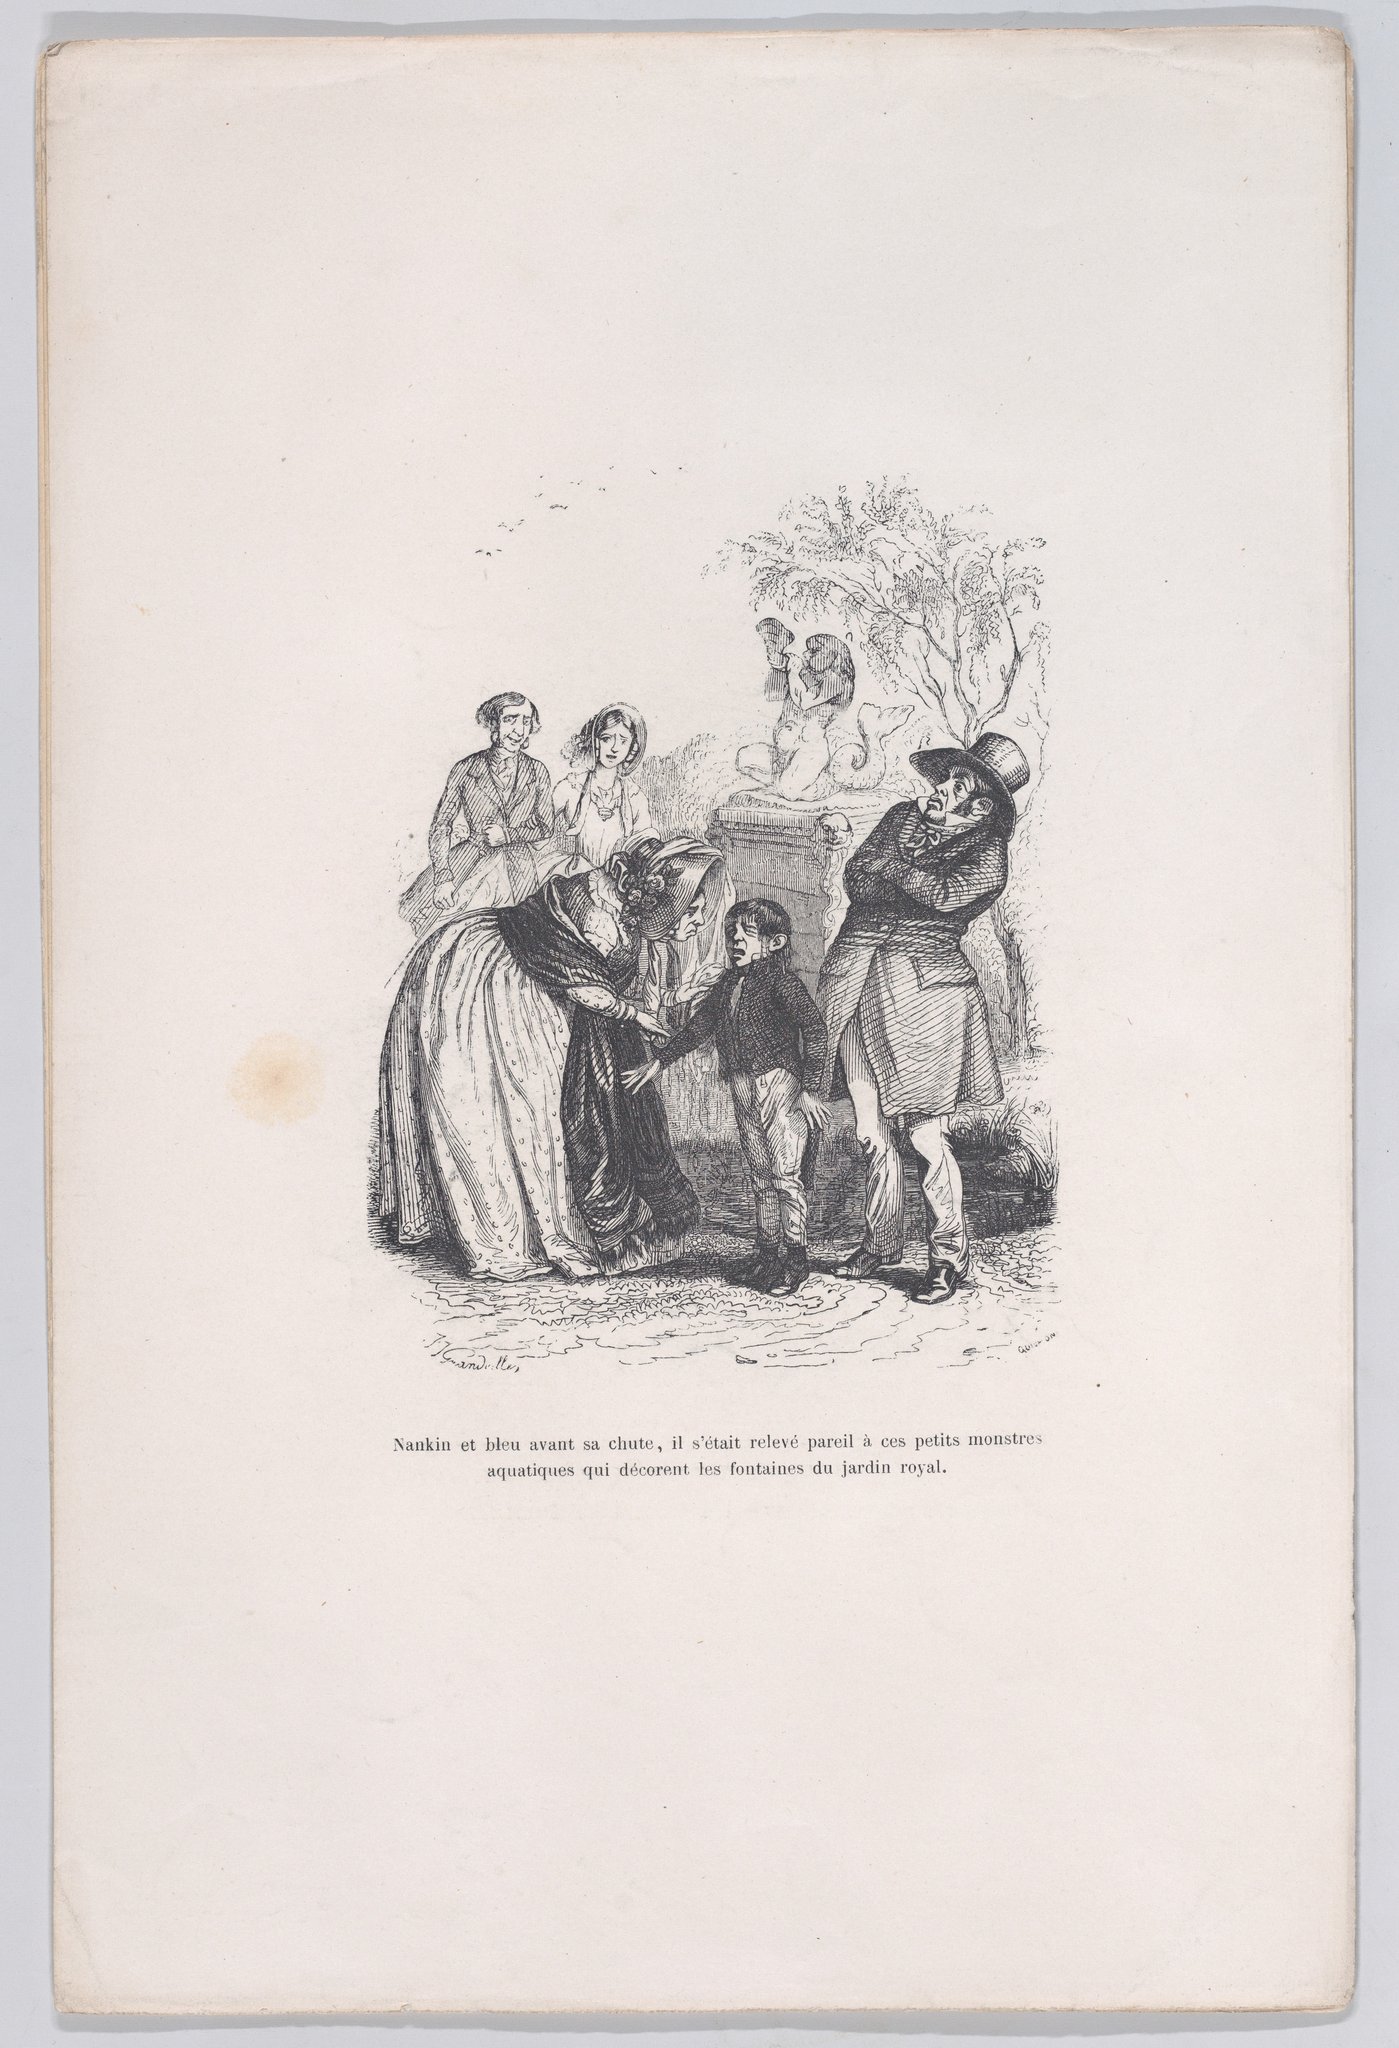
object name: print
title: He rose like those small sea monsters that decorate the fountains, from "Little Miseries of Human Life"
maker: j. j. grandville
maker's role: illustrator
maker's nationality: french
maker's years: 1803-1847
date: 1843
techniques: engraving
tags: boys,men,women